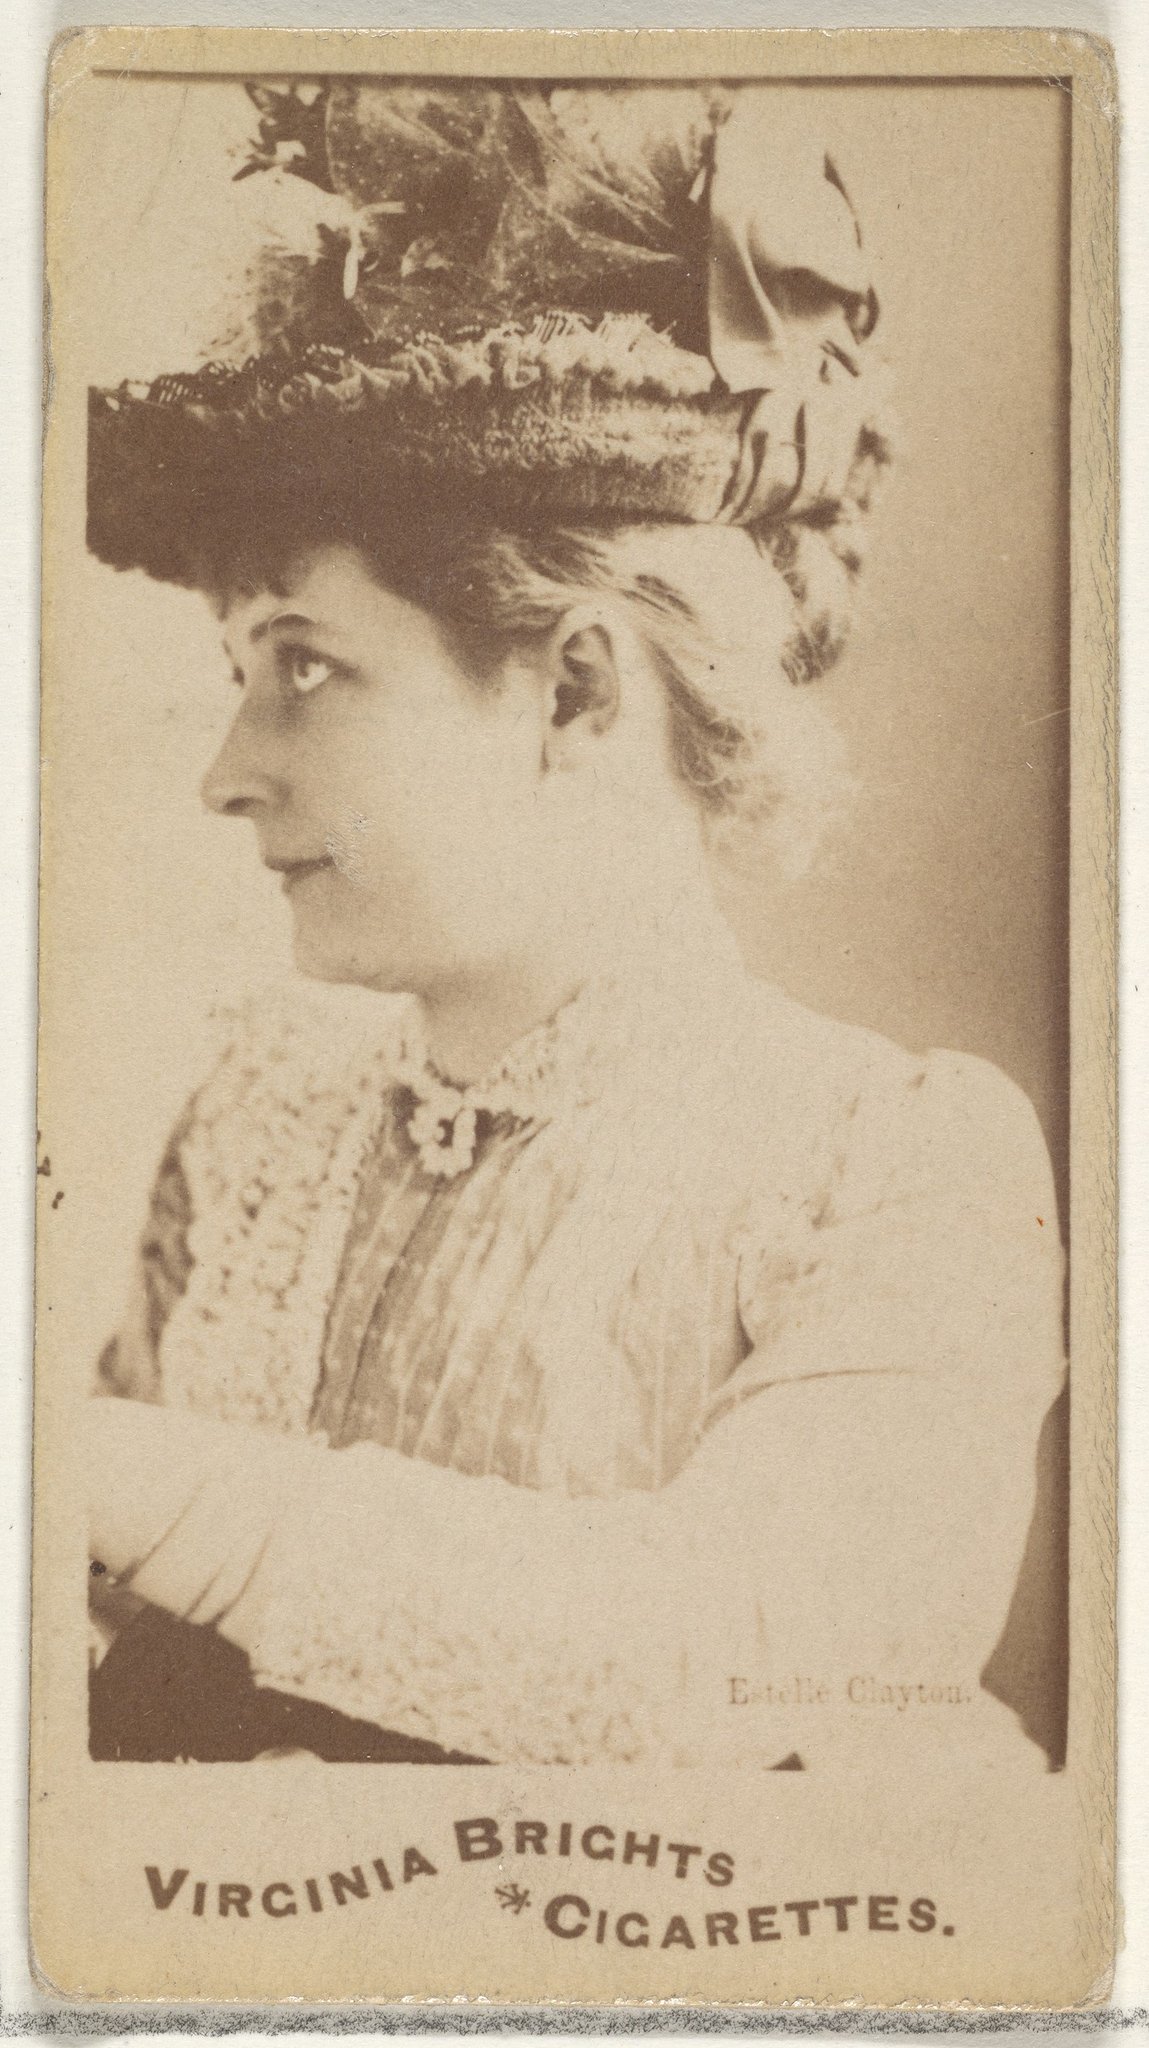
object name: photograph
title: Estelle Clayton, from the Actors and Actresses series (N45, Type 1) for Virginia Brights Cigarettes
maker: allen & ginter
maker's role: publisher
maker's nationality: american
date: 1888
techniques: albumen silver print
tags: portraits,women,actresses